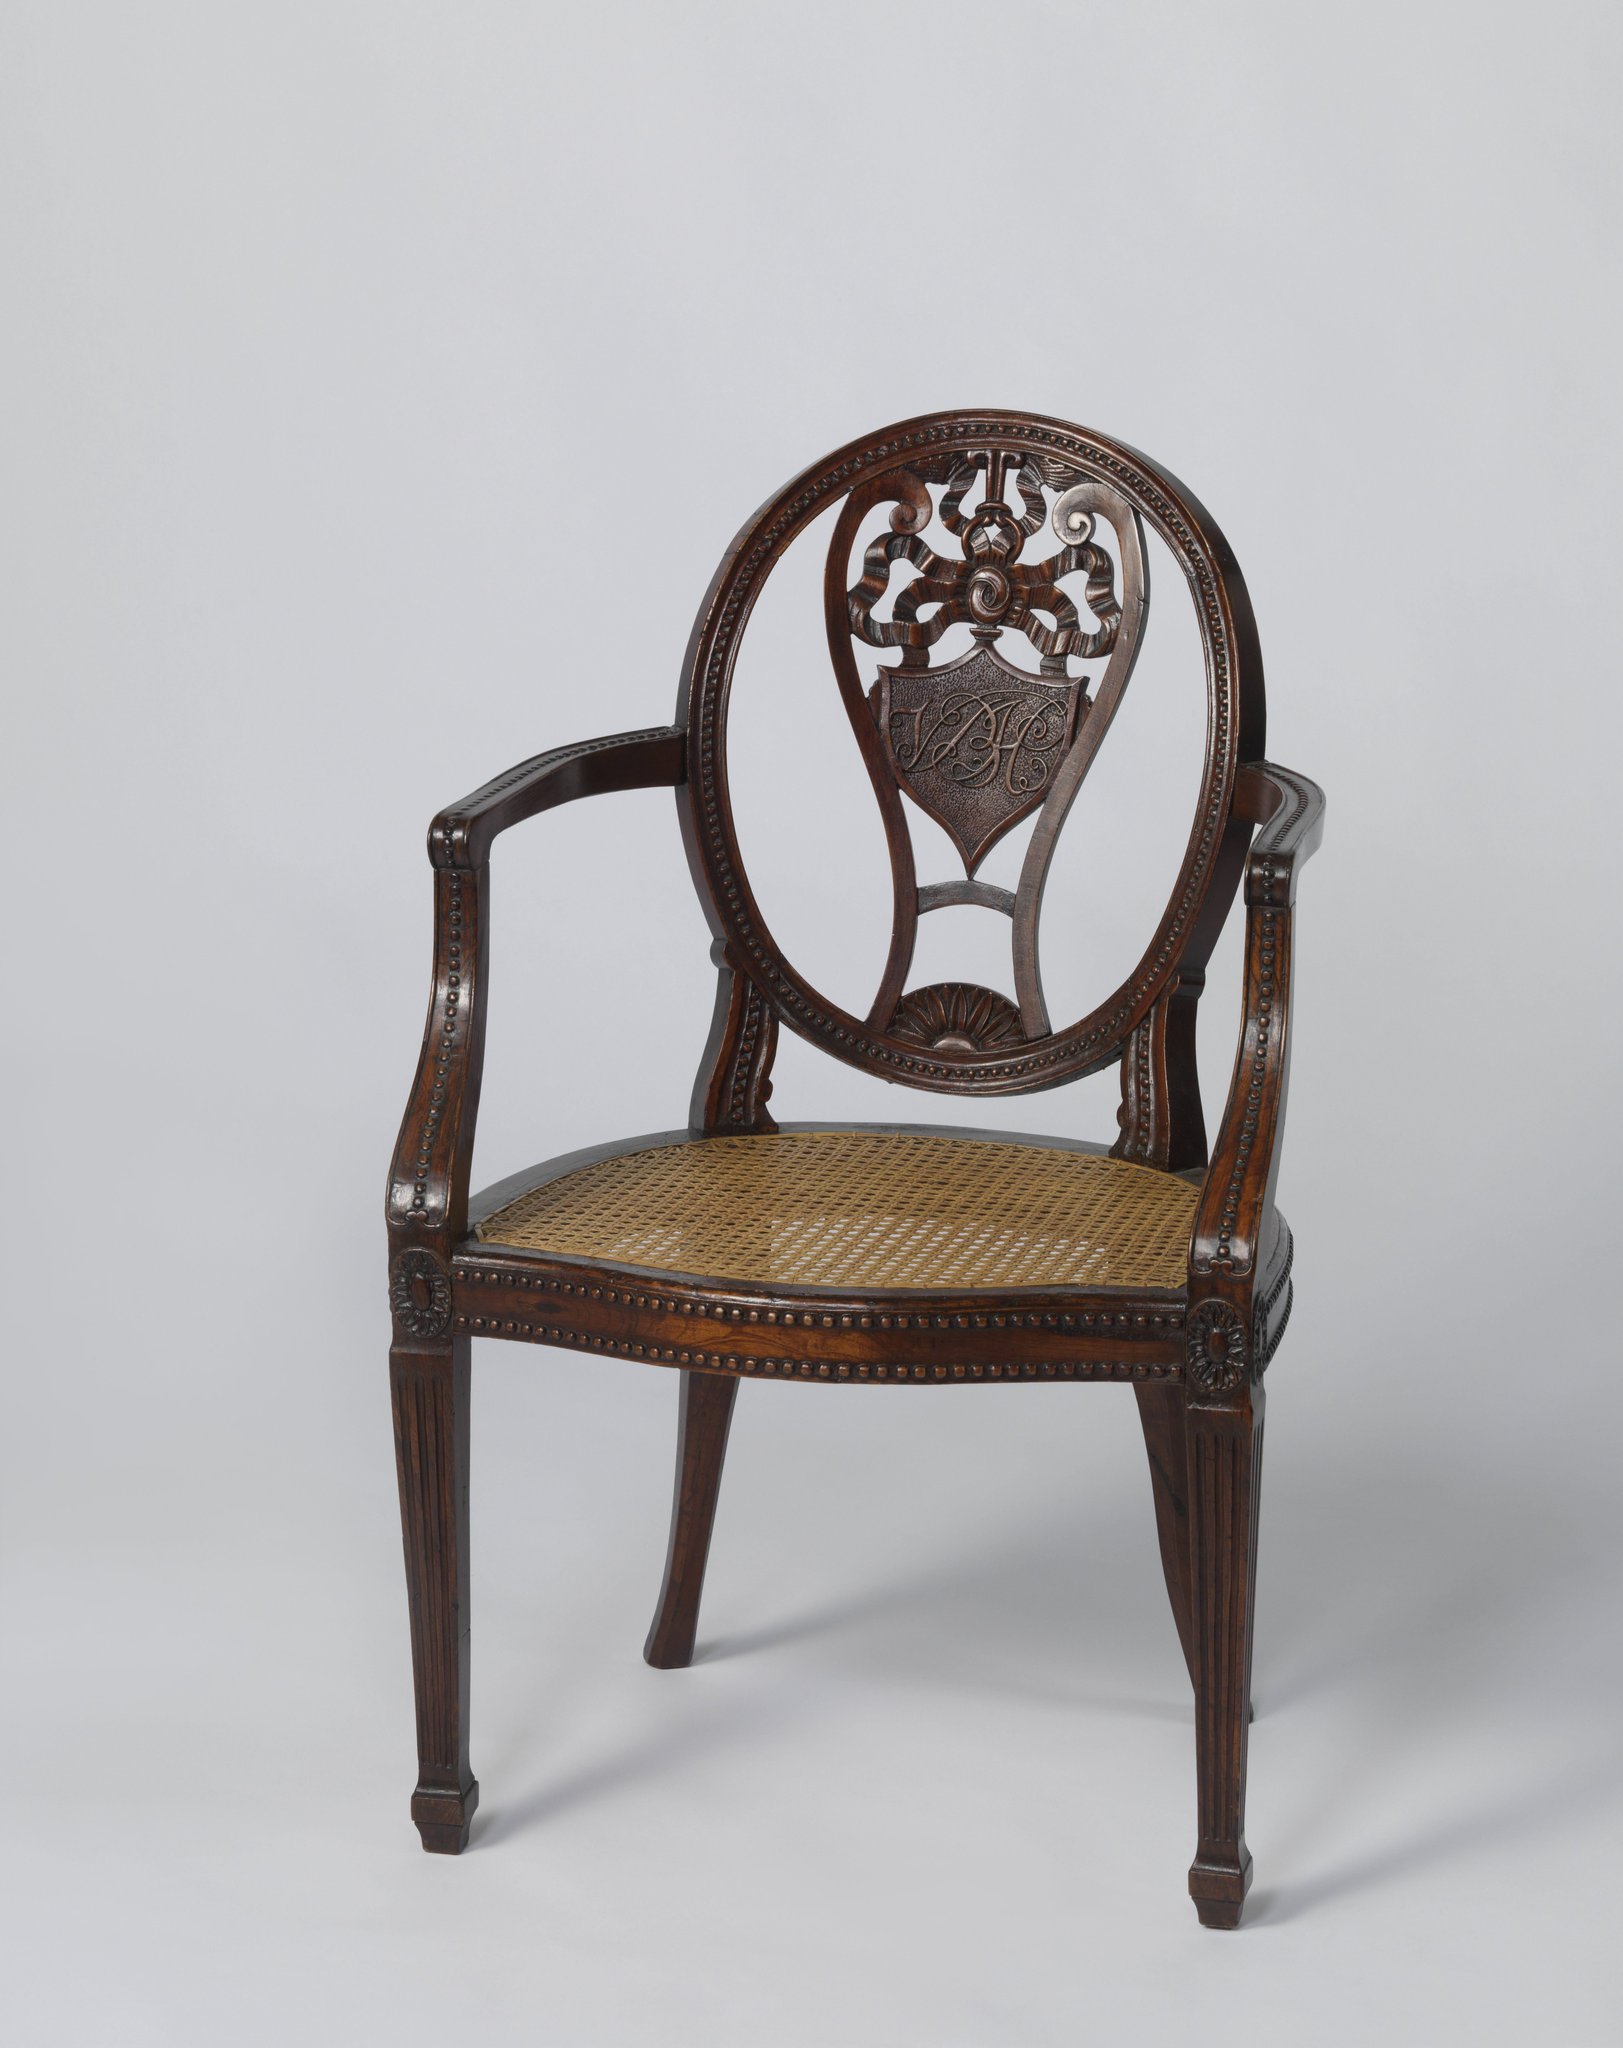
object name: chair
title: Armstoel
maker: Anonymous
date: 1795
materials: rattan, wood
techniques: colour, lacquer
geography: china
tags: amsterdam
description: Armstoel met een ovale gewelfde rugleuning en een matten zitting. De middenplank is opengewerkt in de vorm van een lier met een wapenschild waarin de letters VBH (Van Braam Houckgeest) in reliëf zijn aangebracht. Op de rugleuning, de armrusten en de armstutten een parelrand; gecanneleerde voorpoten en rozetten boven de poten.